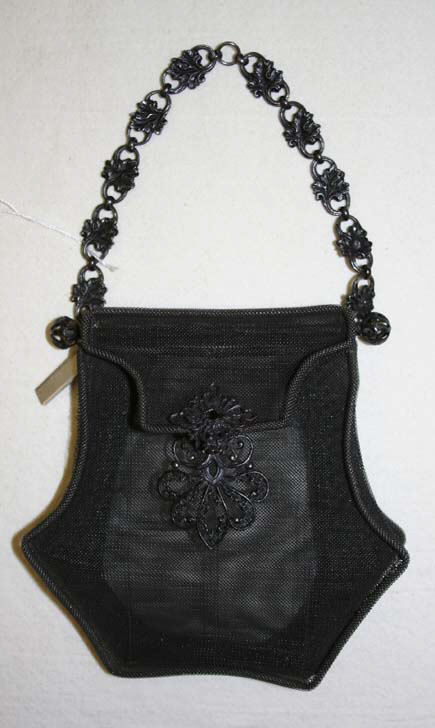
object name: purse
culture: european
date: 1873